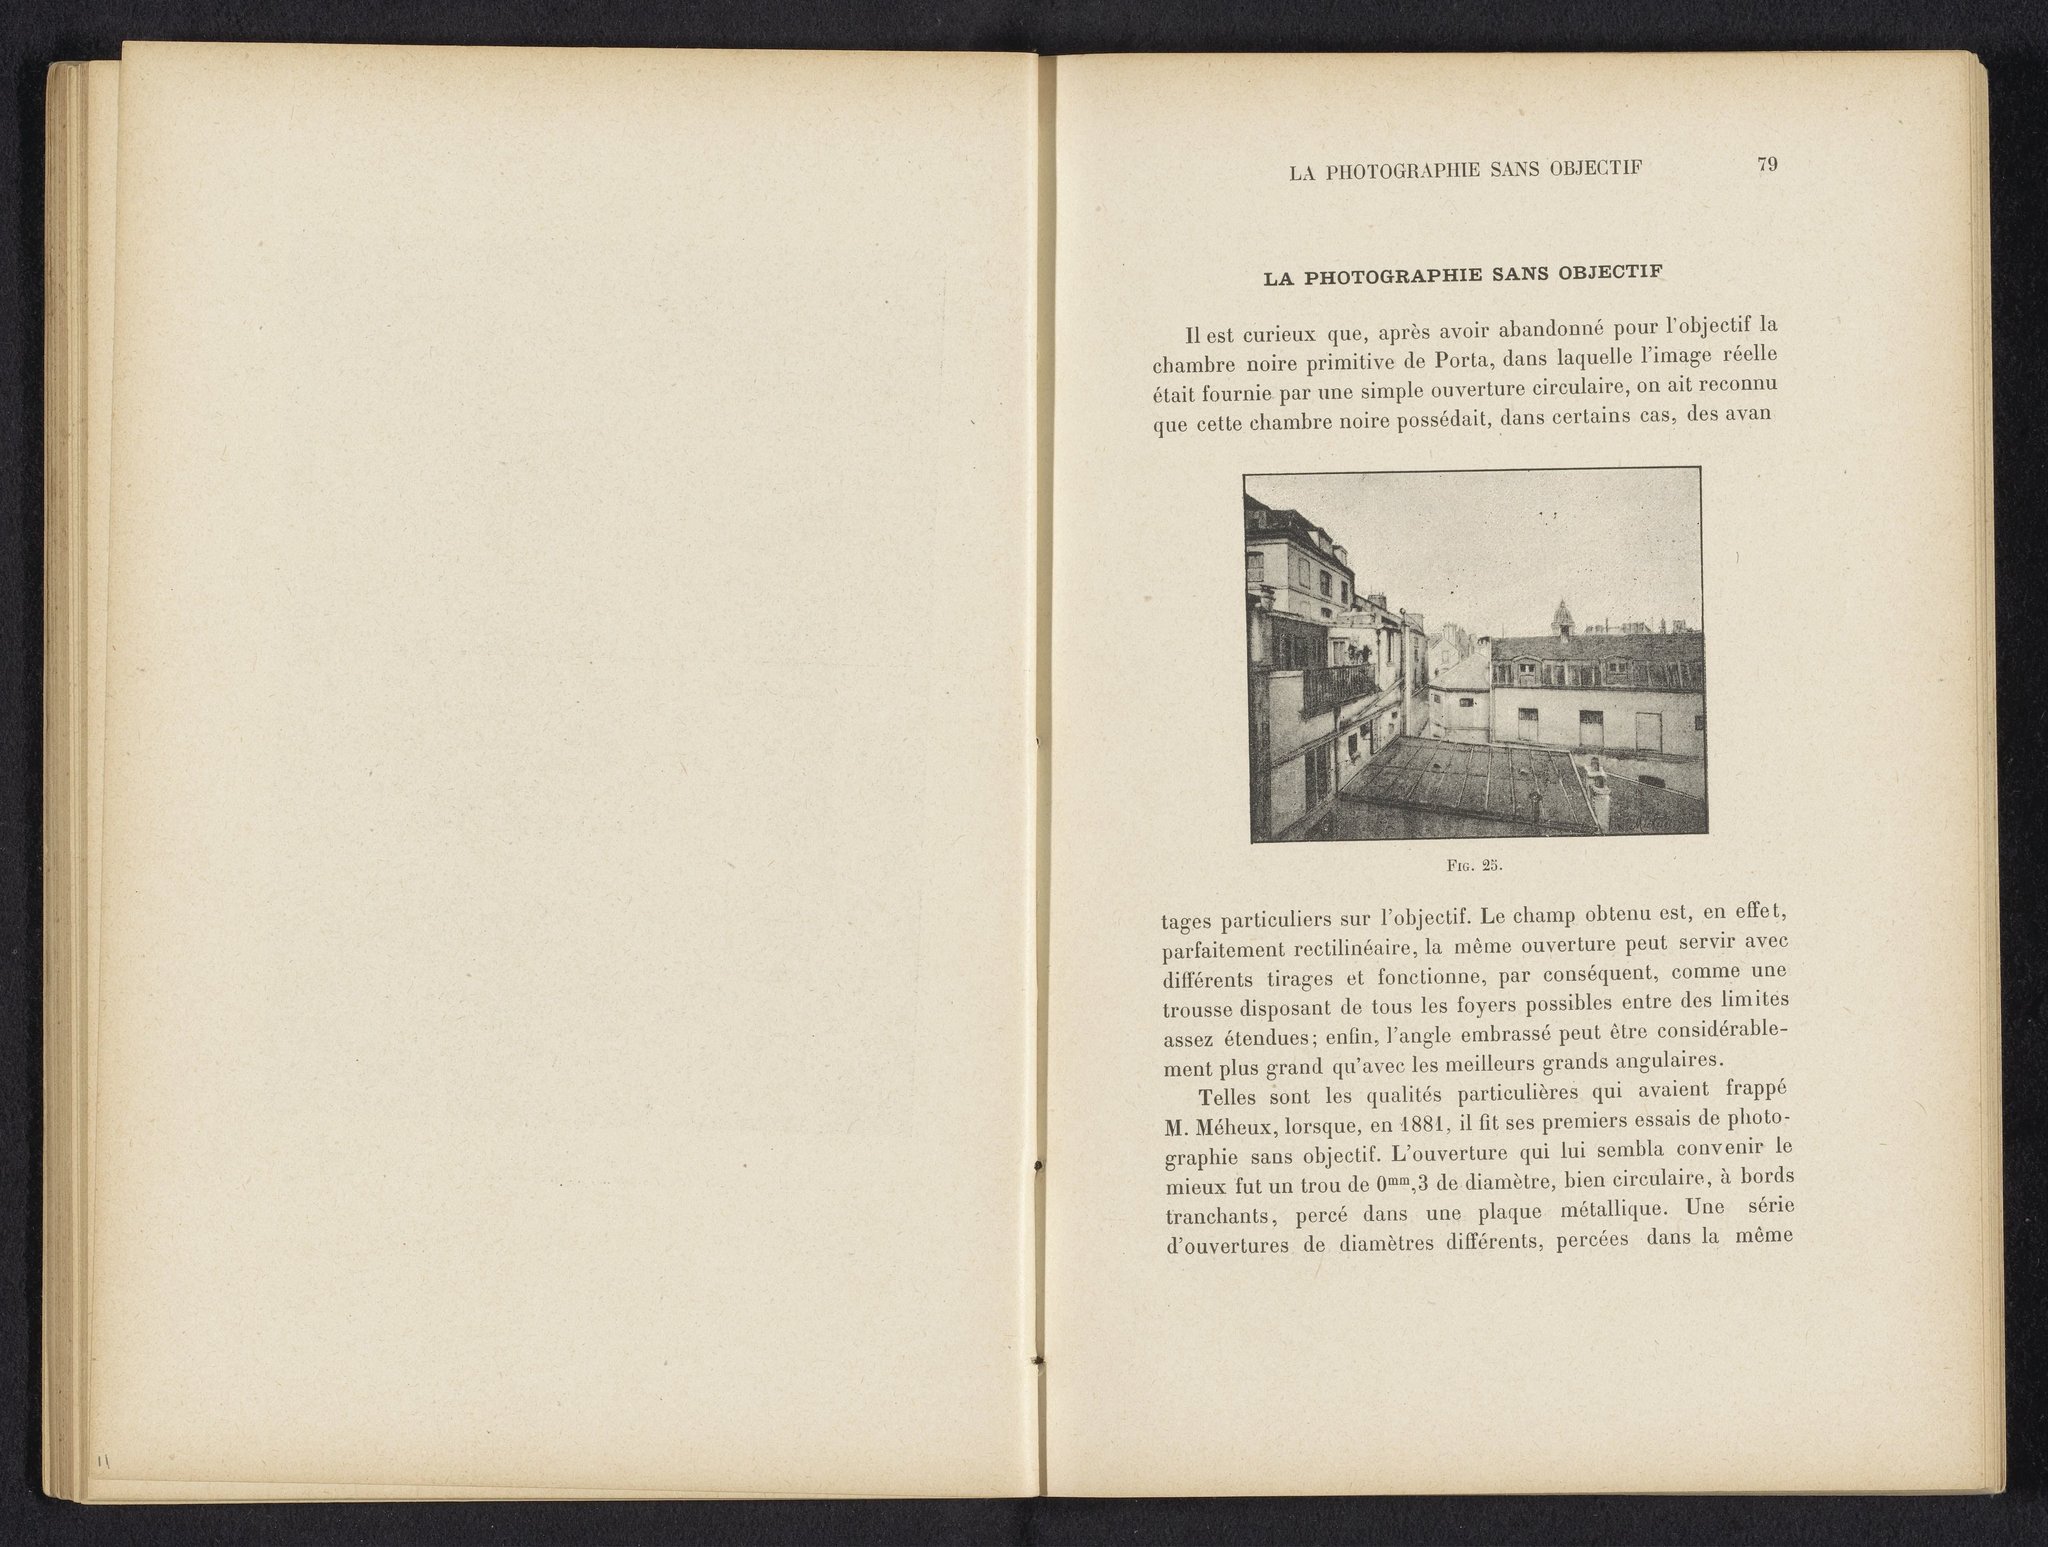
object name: photomechanical print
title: Gezicht op huizen en daken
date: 1883-1893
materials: paper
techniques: autotype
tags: roof (of house or building)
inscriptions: number: ‘Fig. 25.’, name: ‘Michelets S.G.’